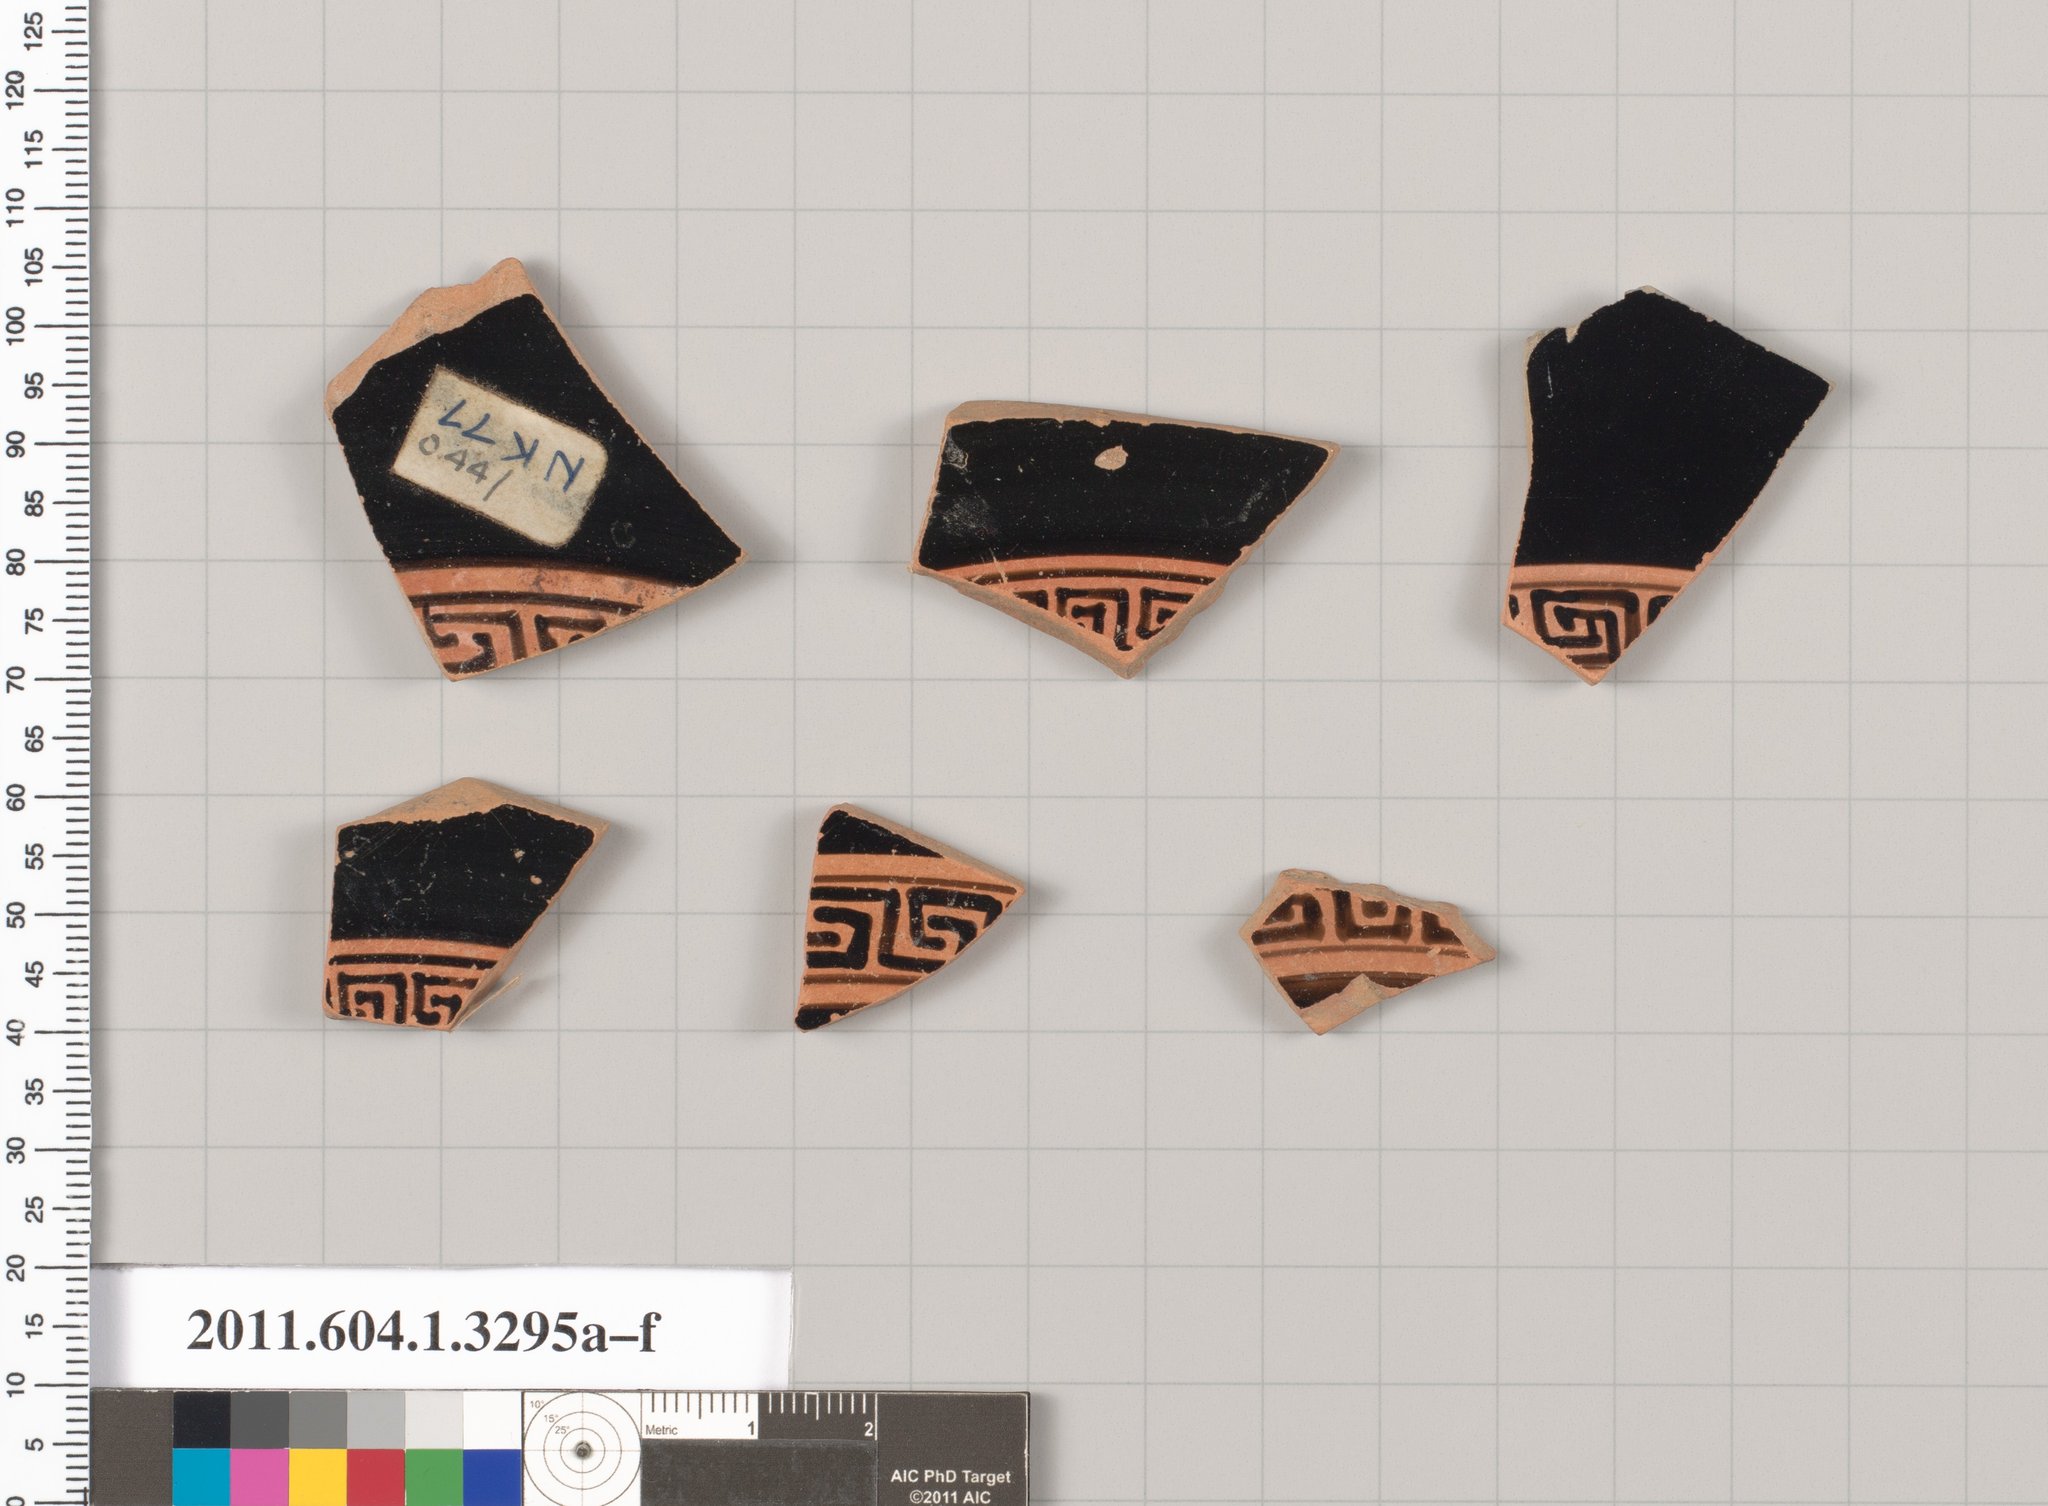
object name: kylix fragment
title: Terracotta fragments of kylikes (drinking cups)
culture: greek, attic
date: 500-480 BCE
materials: terracotta